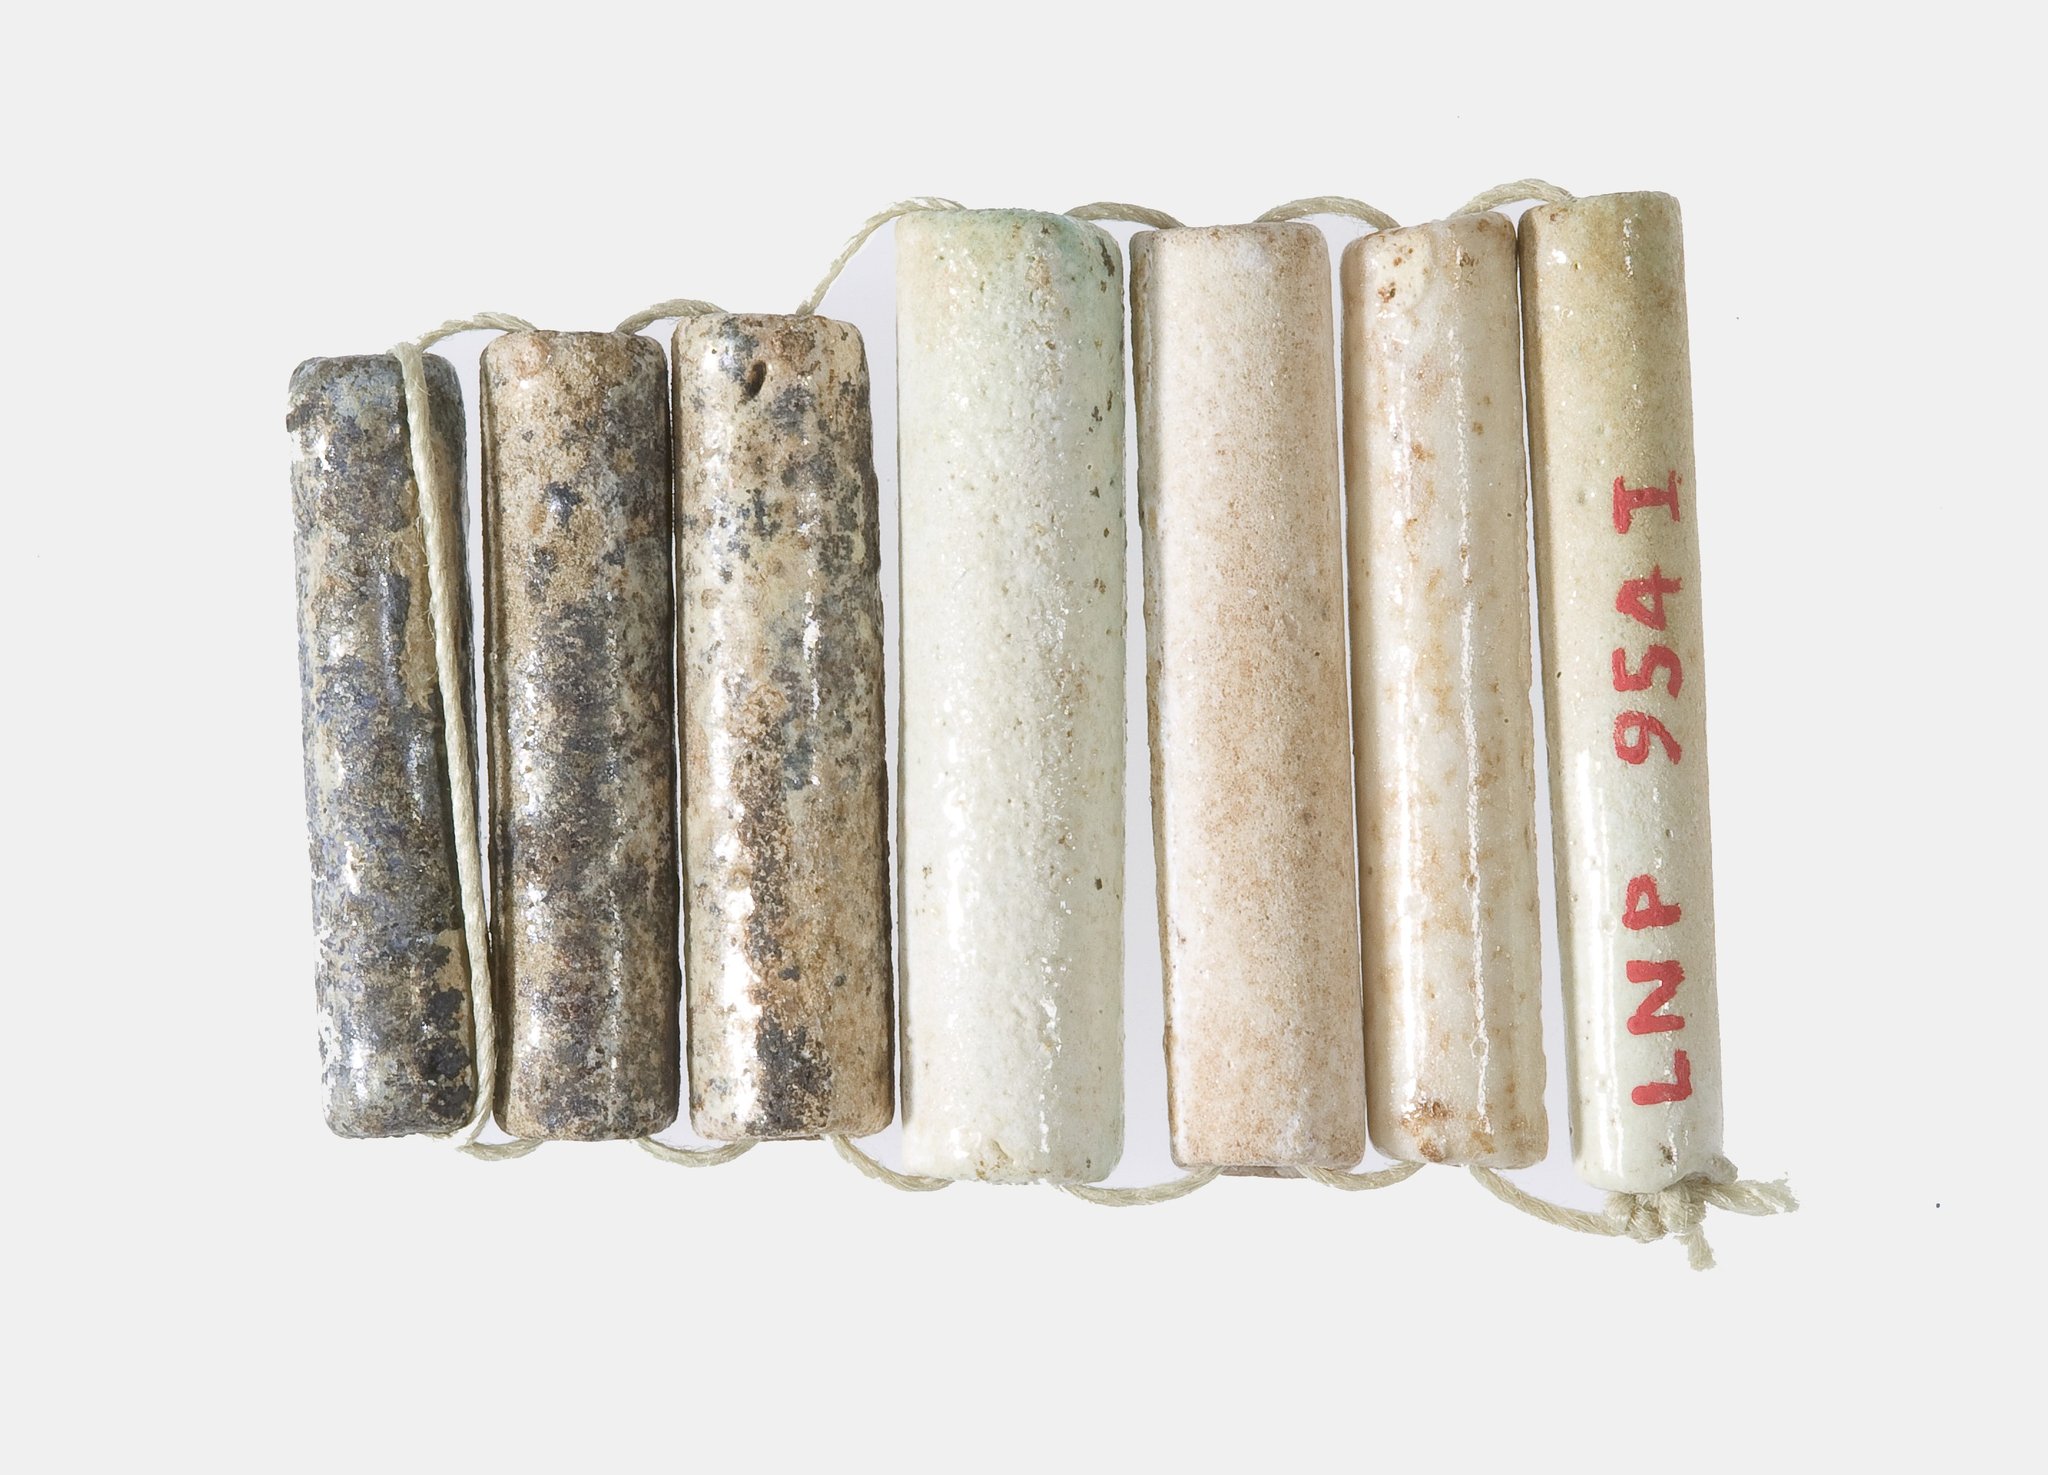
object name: bead, string, cylinder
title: Cylinder beads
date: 1981-1640 BCE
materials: faience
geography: egypt